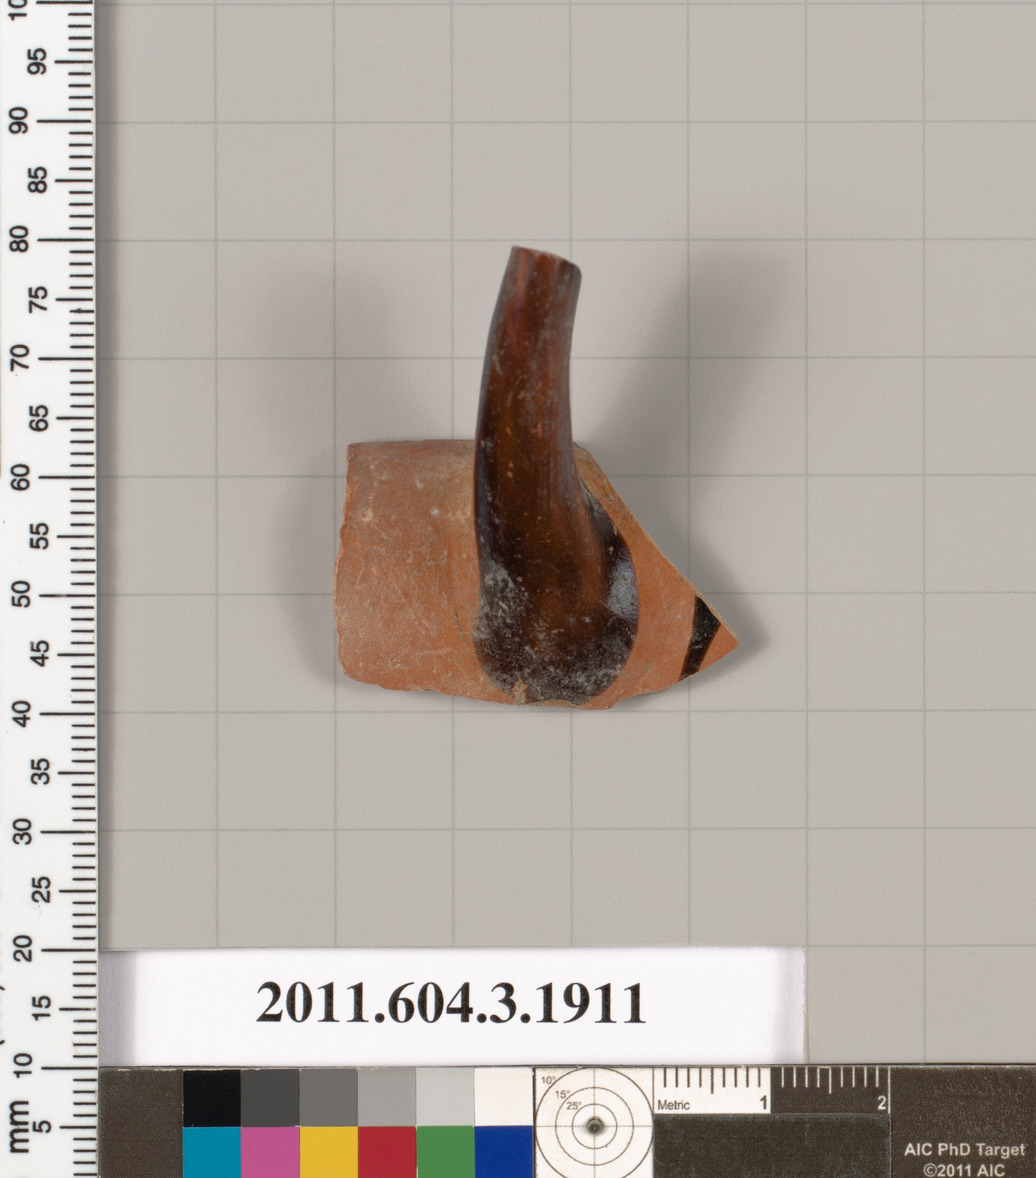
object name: kylix or skyphos fragment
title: Terracotta fragment of a kylix (drinking cup) or a skyphos (deep drinking cup)?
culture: greek, attic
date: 534-468 BCE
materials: terracotta